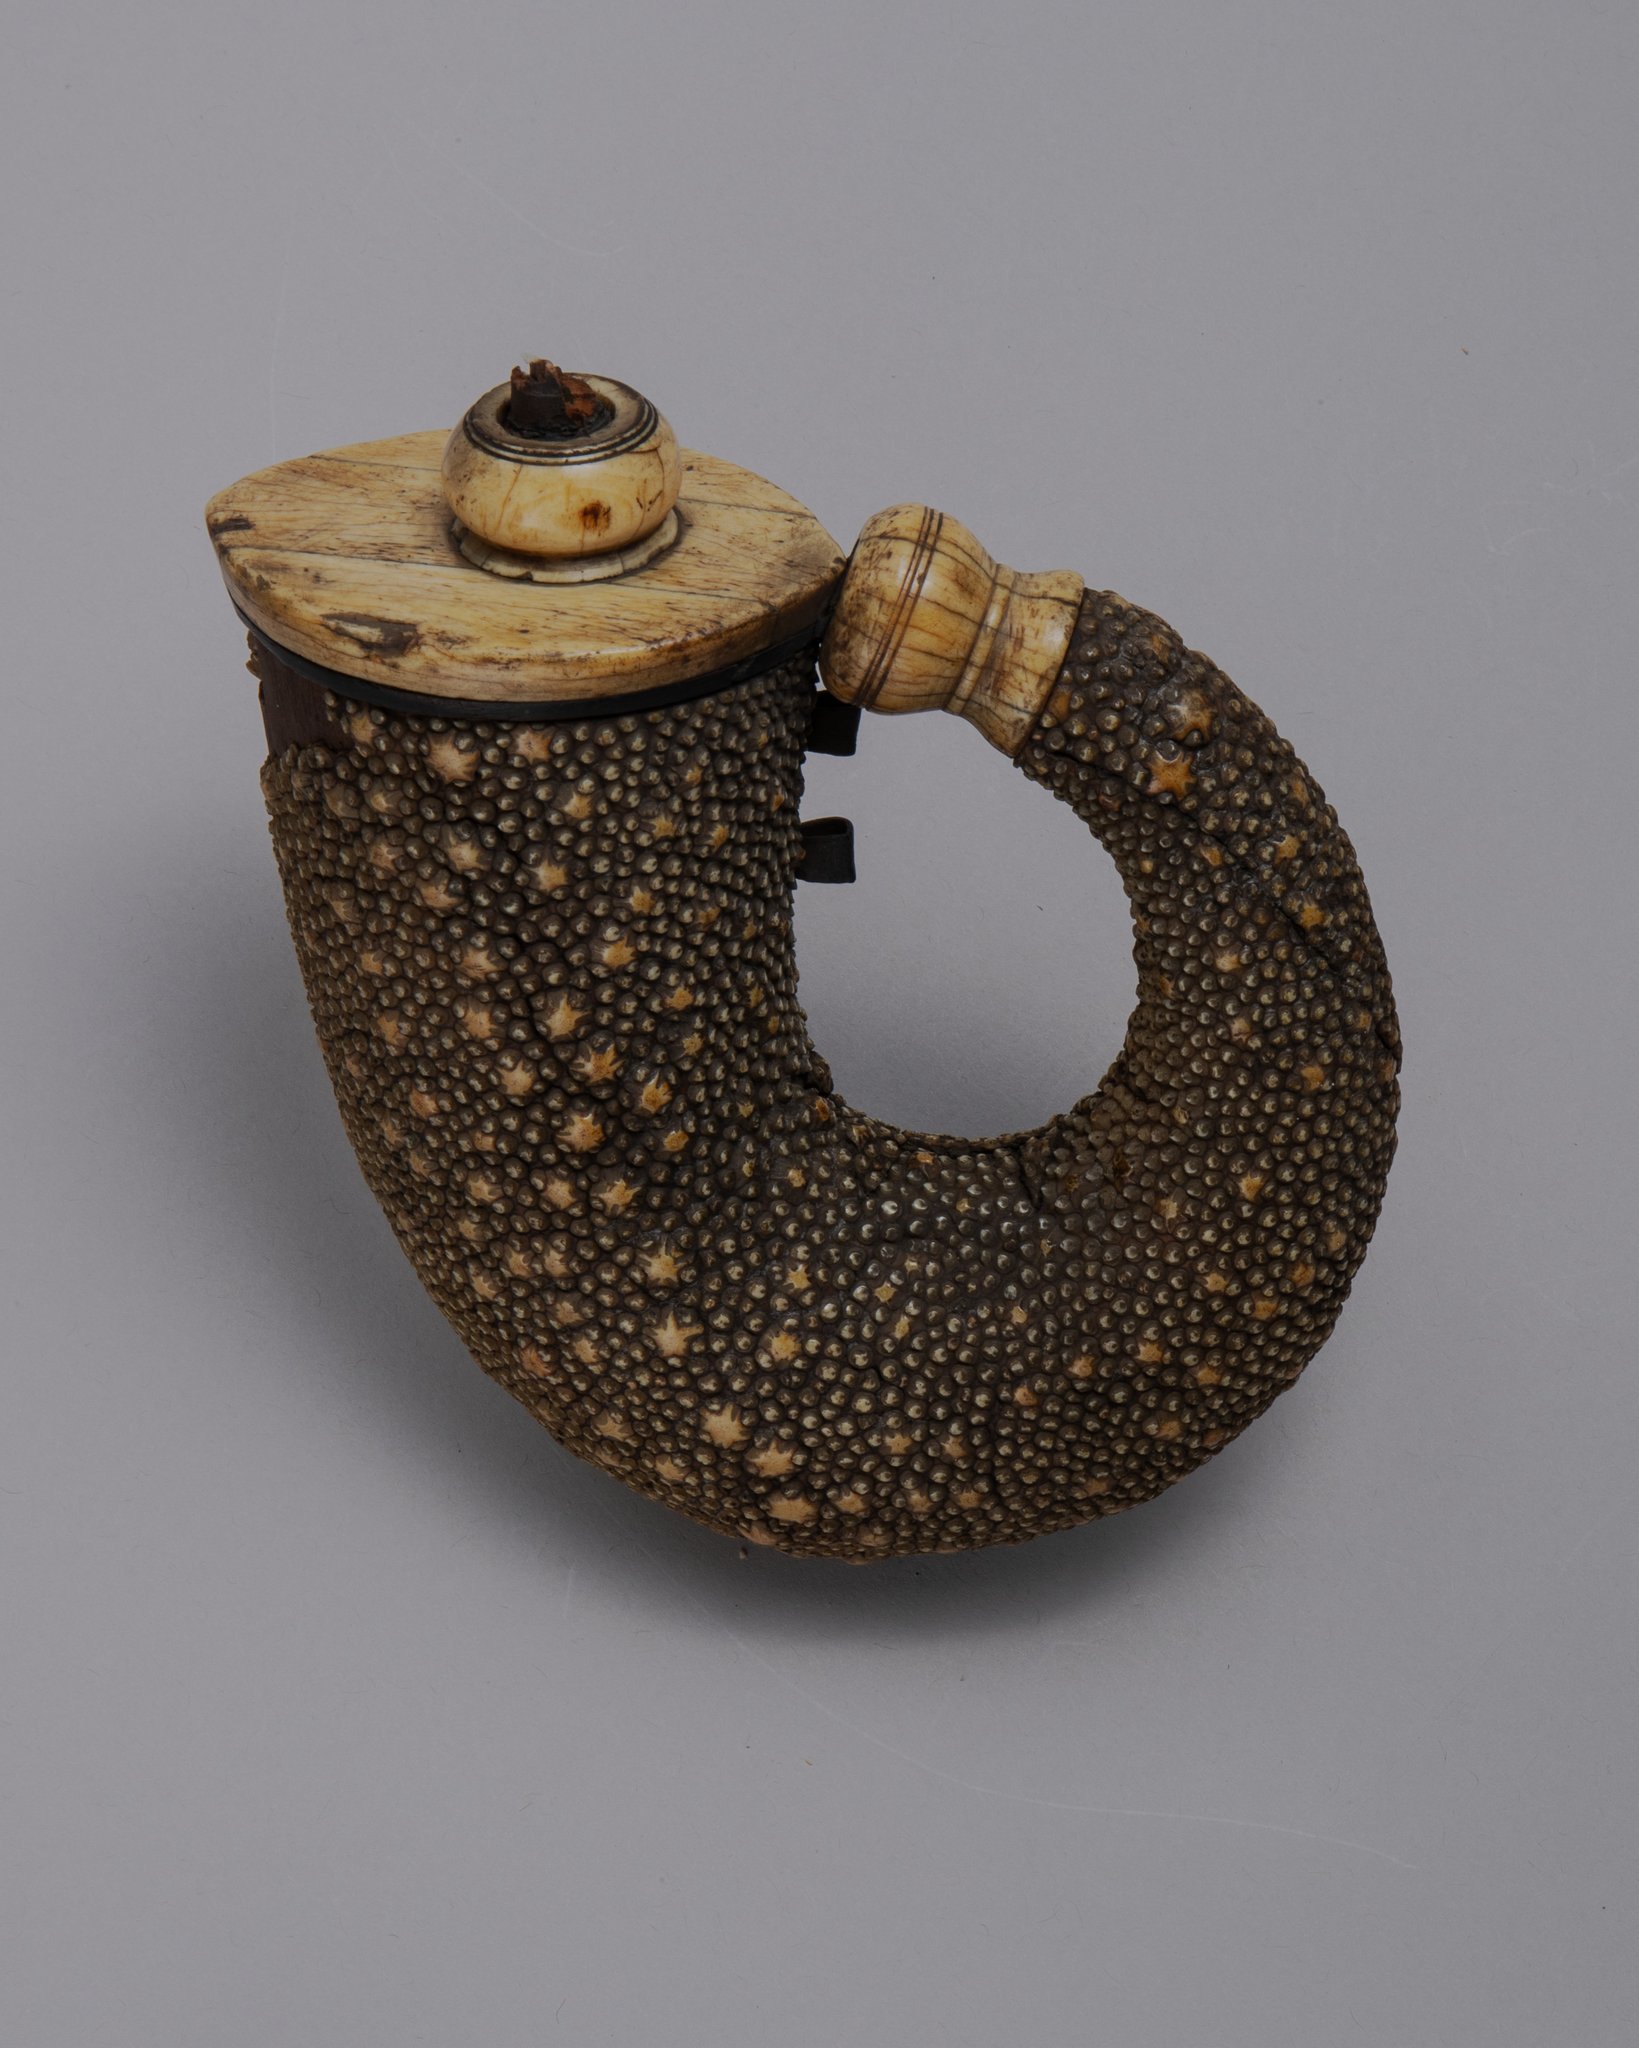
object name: powder flask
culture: indian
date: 1701-1800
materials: ivory, wood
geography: india